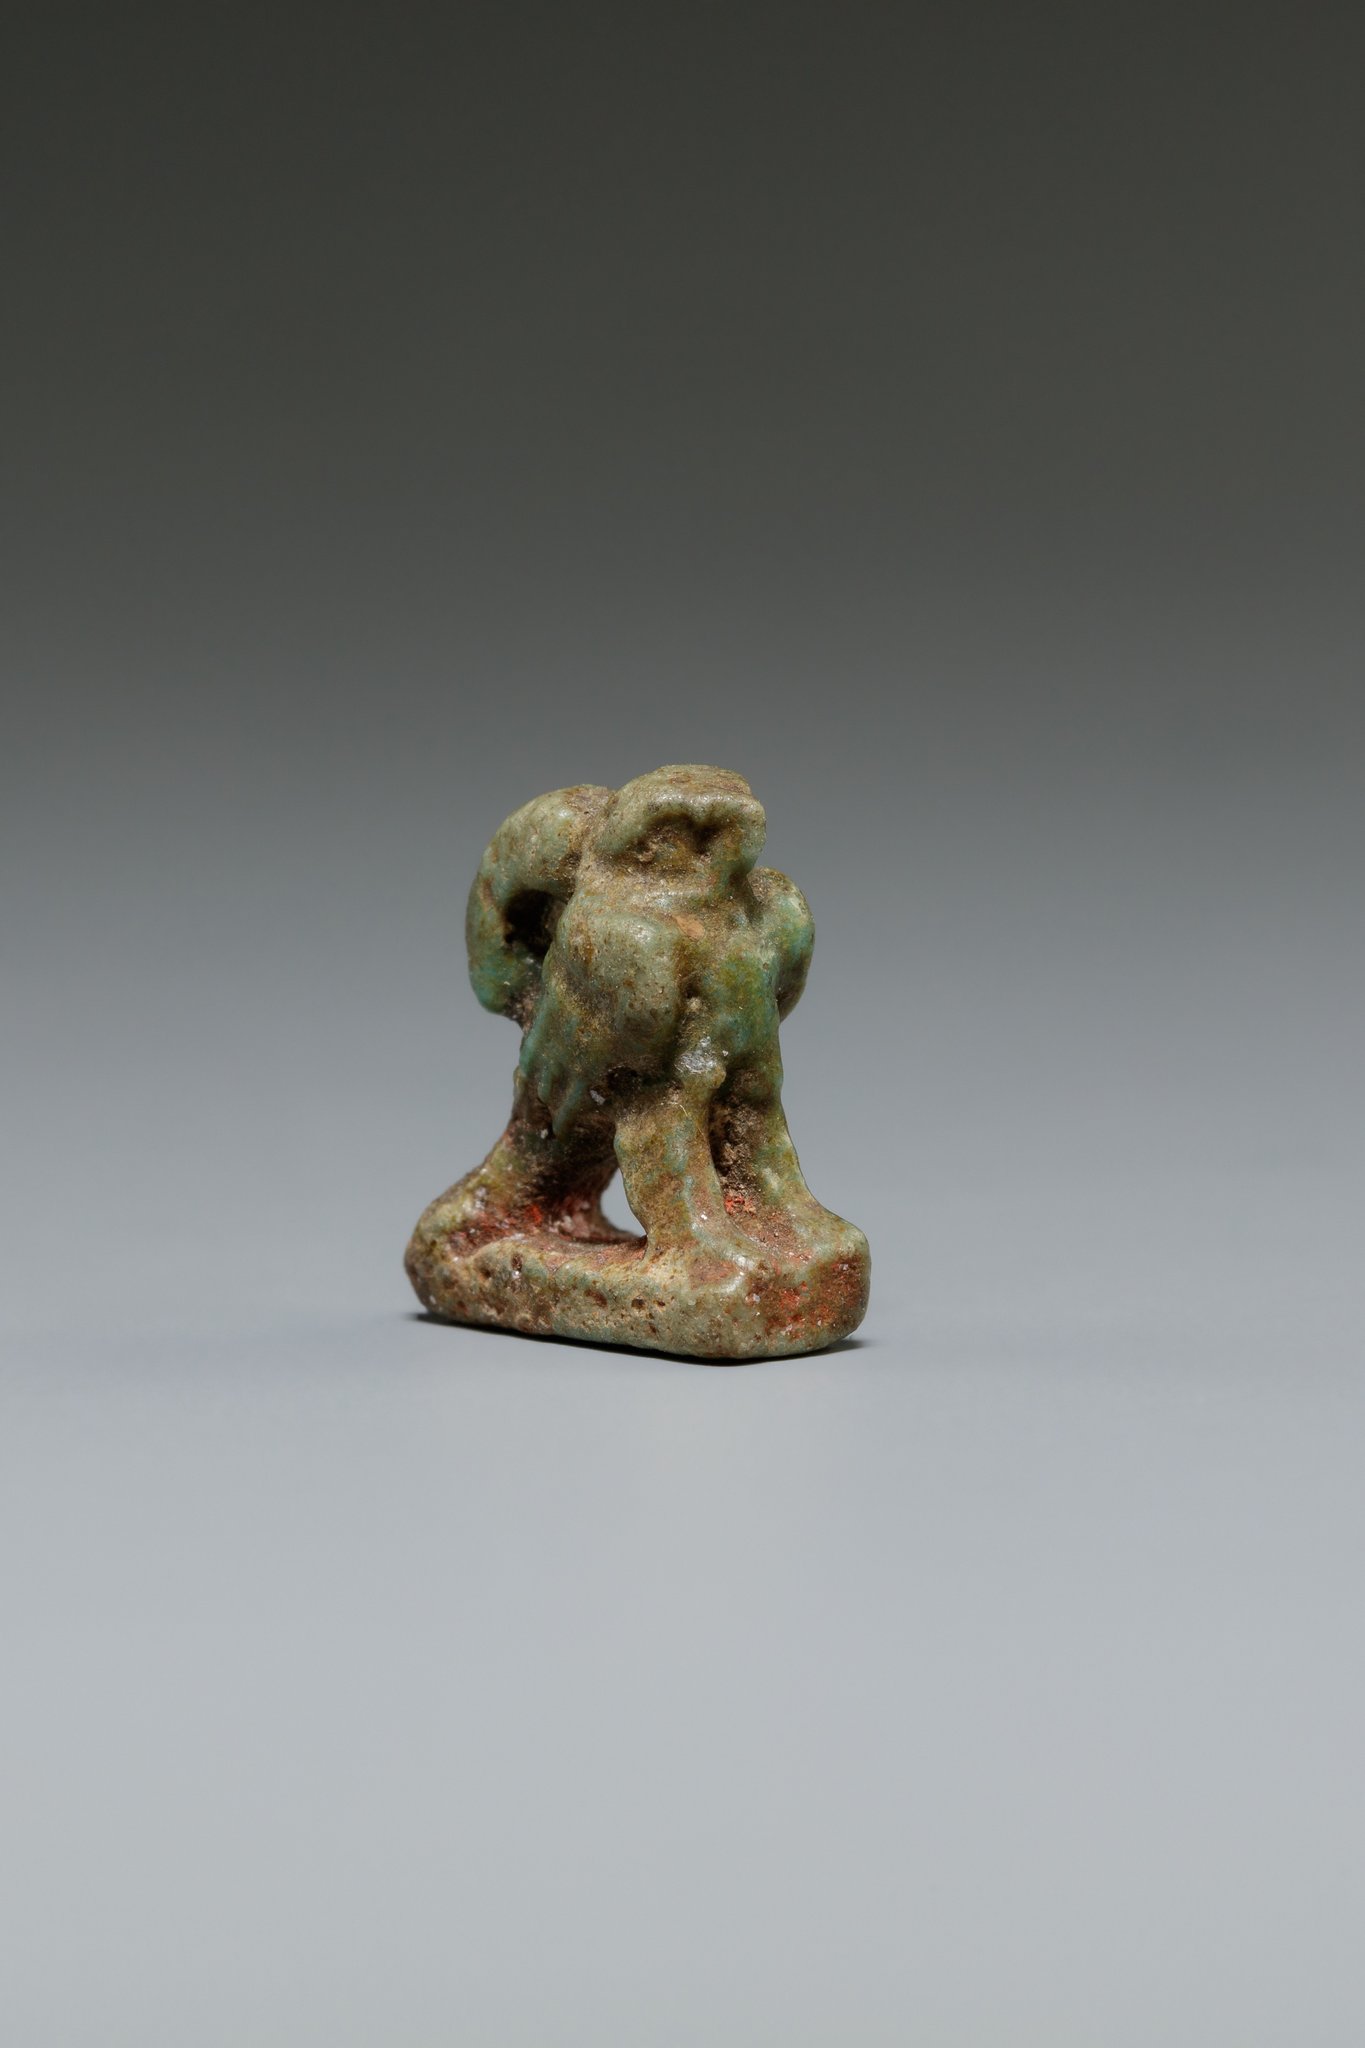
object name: amulet, falcon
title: Falcon amulet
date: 664-630 BCE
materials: faience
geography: egypt